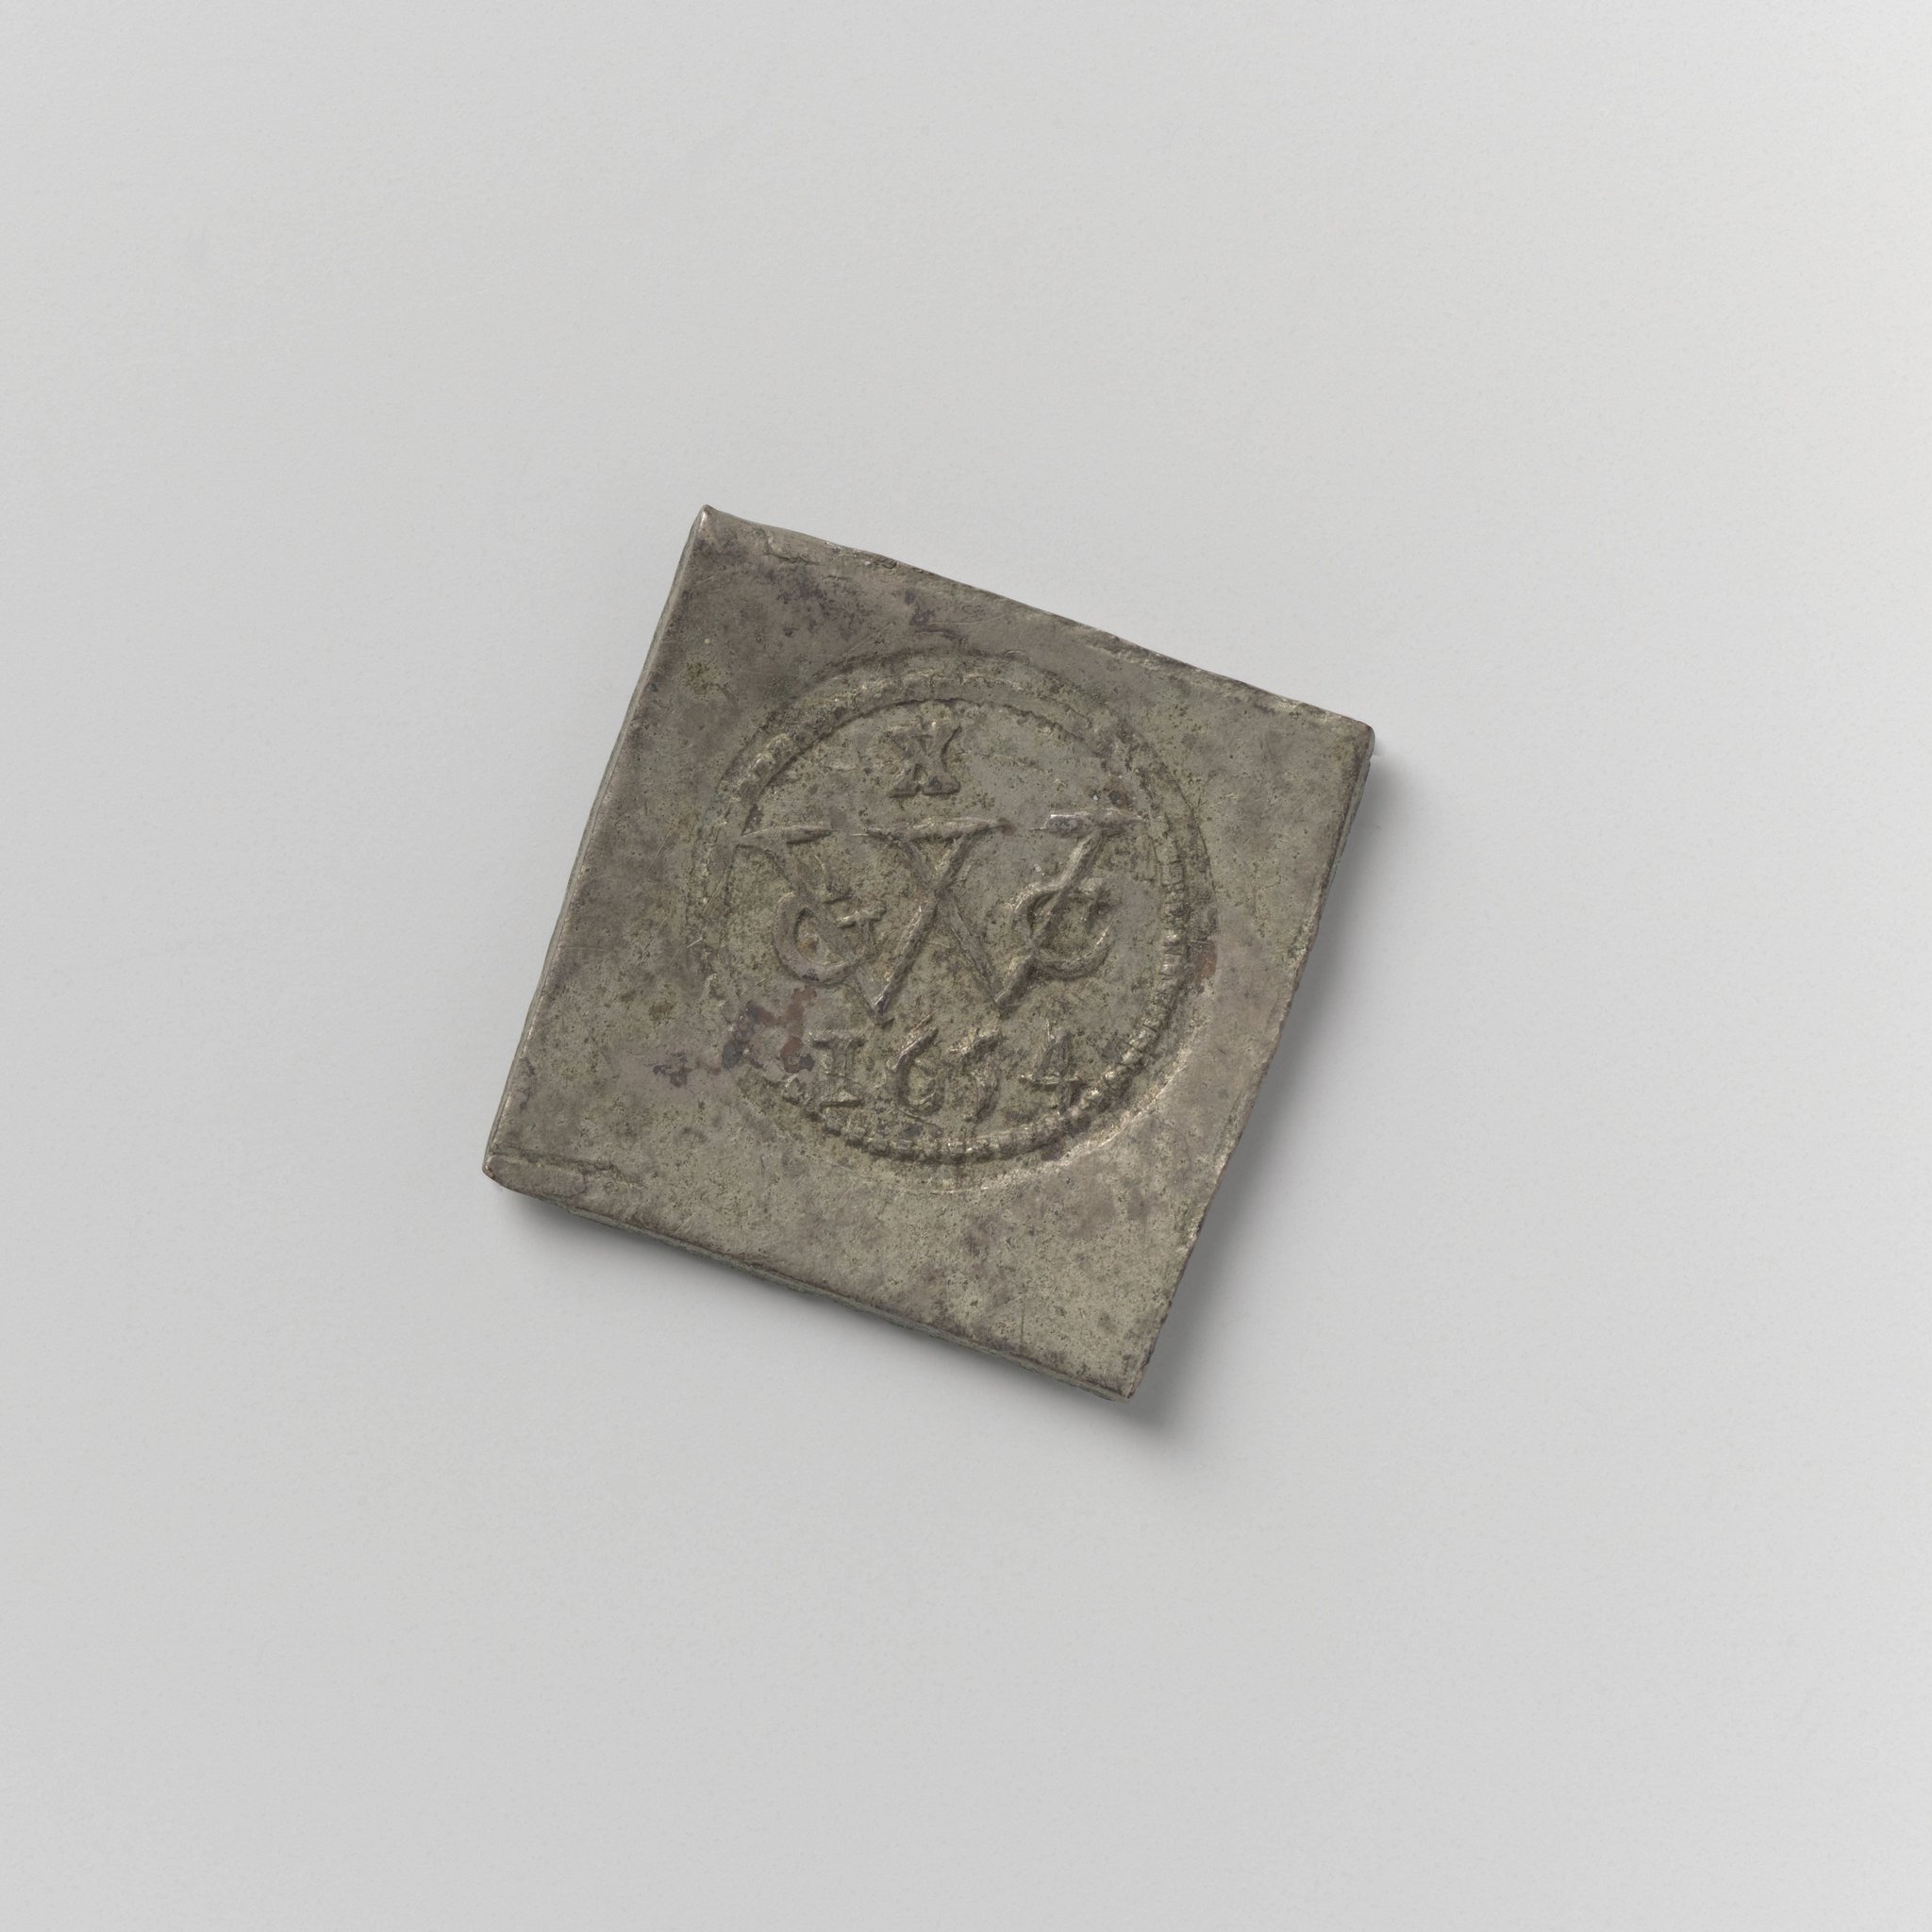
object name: coin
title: Tien stuiver, noodmunt uit Pernambuco, geslagen tijdens het beleg op last van de Nederlandse Westindische Compagnie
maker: Anonymous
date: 1654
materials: silver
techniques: striking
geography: pernambuco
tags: west-indische compagnie, pernambuco, beleg van pernambuco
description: Eenzijdige, ruitvormige, zilveren noodmunt. Voorzijde: binnen ronde parelrand: monogram van letters G, W en C onder Romeinse cijfer X. Keerzijde: blanco.